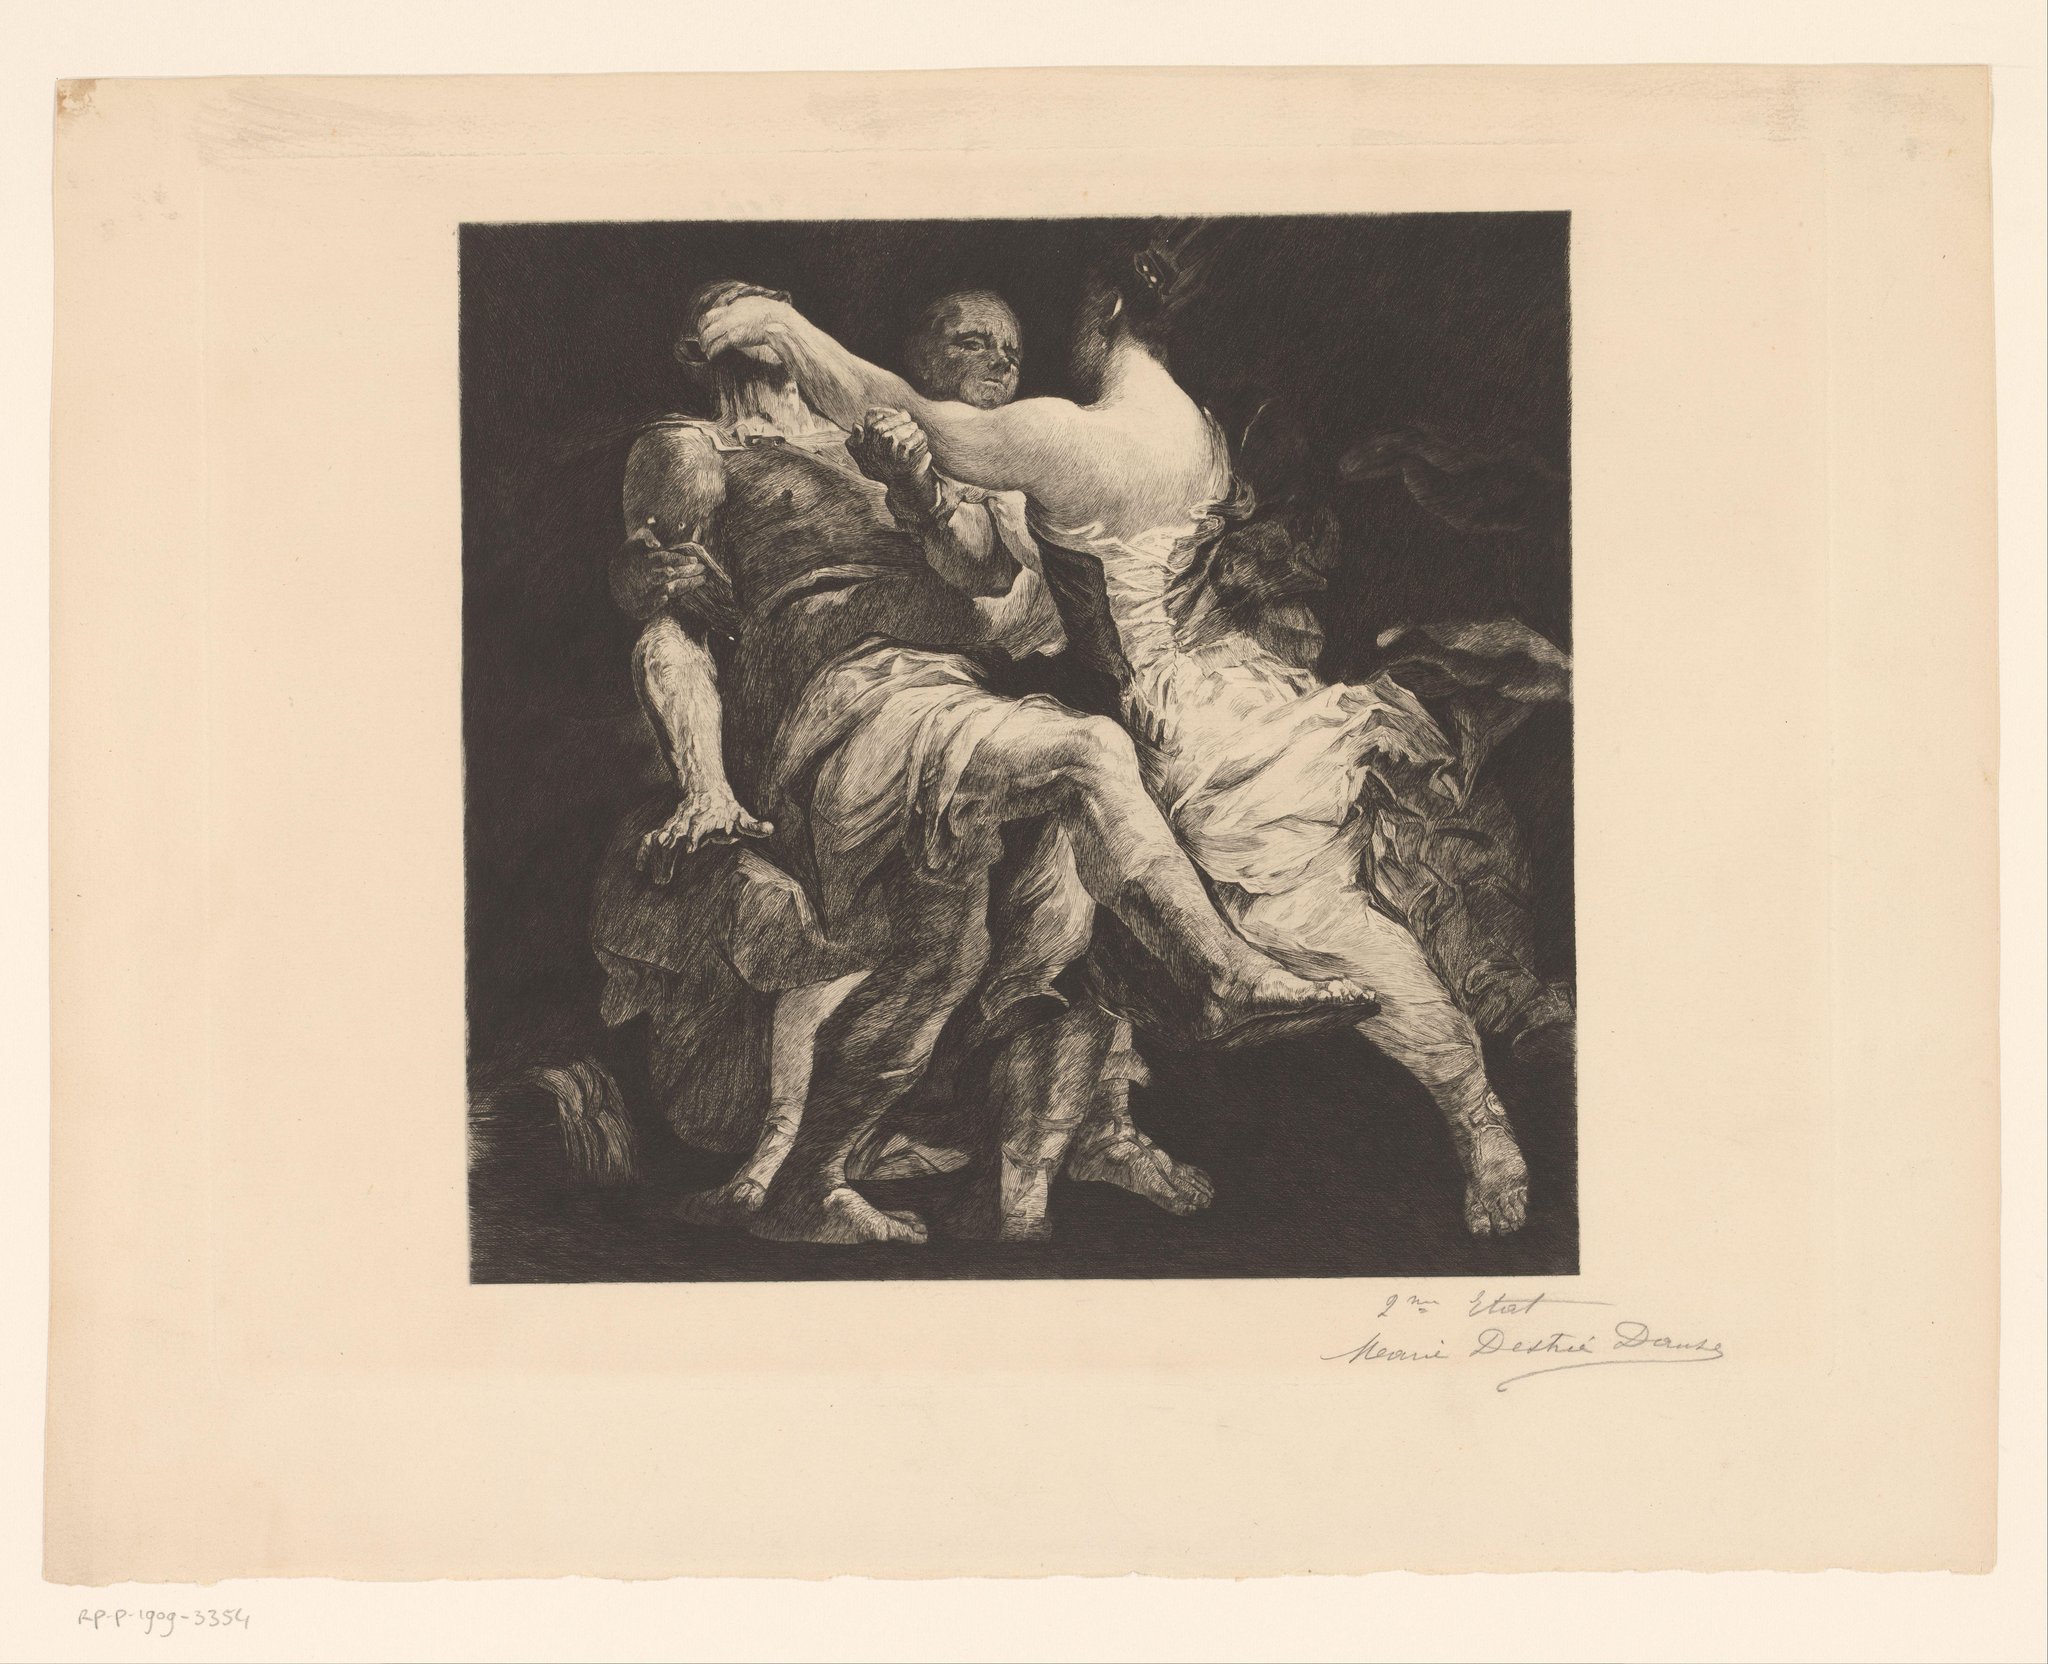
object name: print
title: Hekabe maakt Polymestor blind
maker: marie danse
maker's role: print maker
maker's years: 1867-1942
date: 1889-1909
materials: paper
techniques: drypoint, etching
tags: hecuba tears out polymnestor's eyes and kills his two sons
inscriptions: inscription: ‘2me Etat’, collector's mark: Lugt 2228